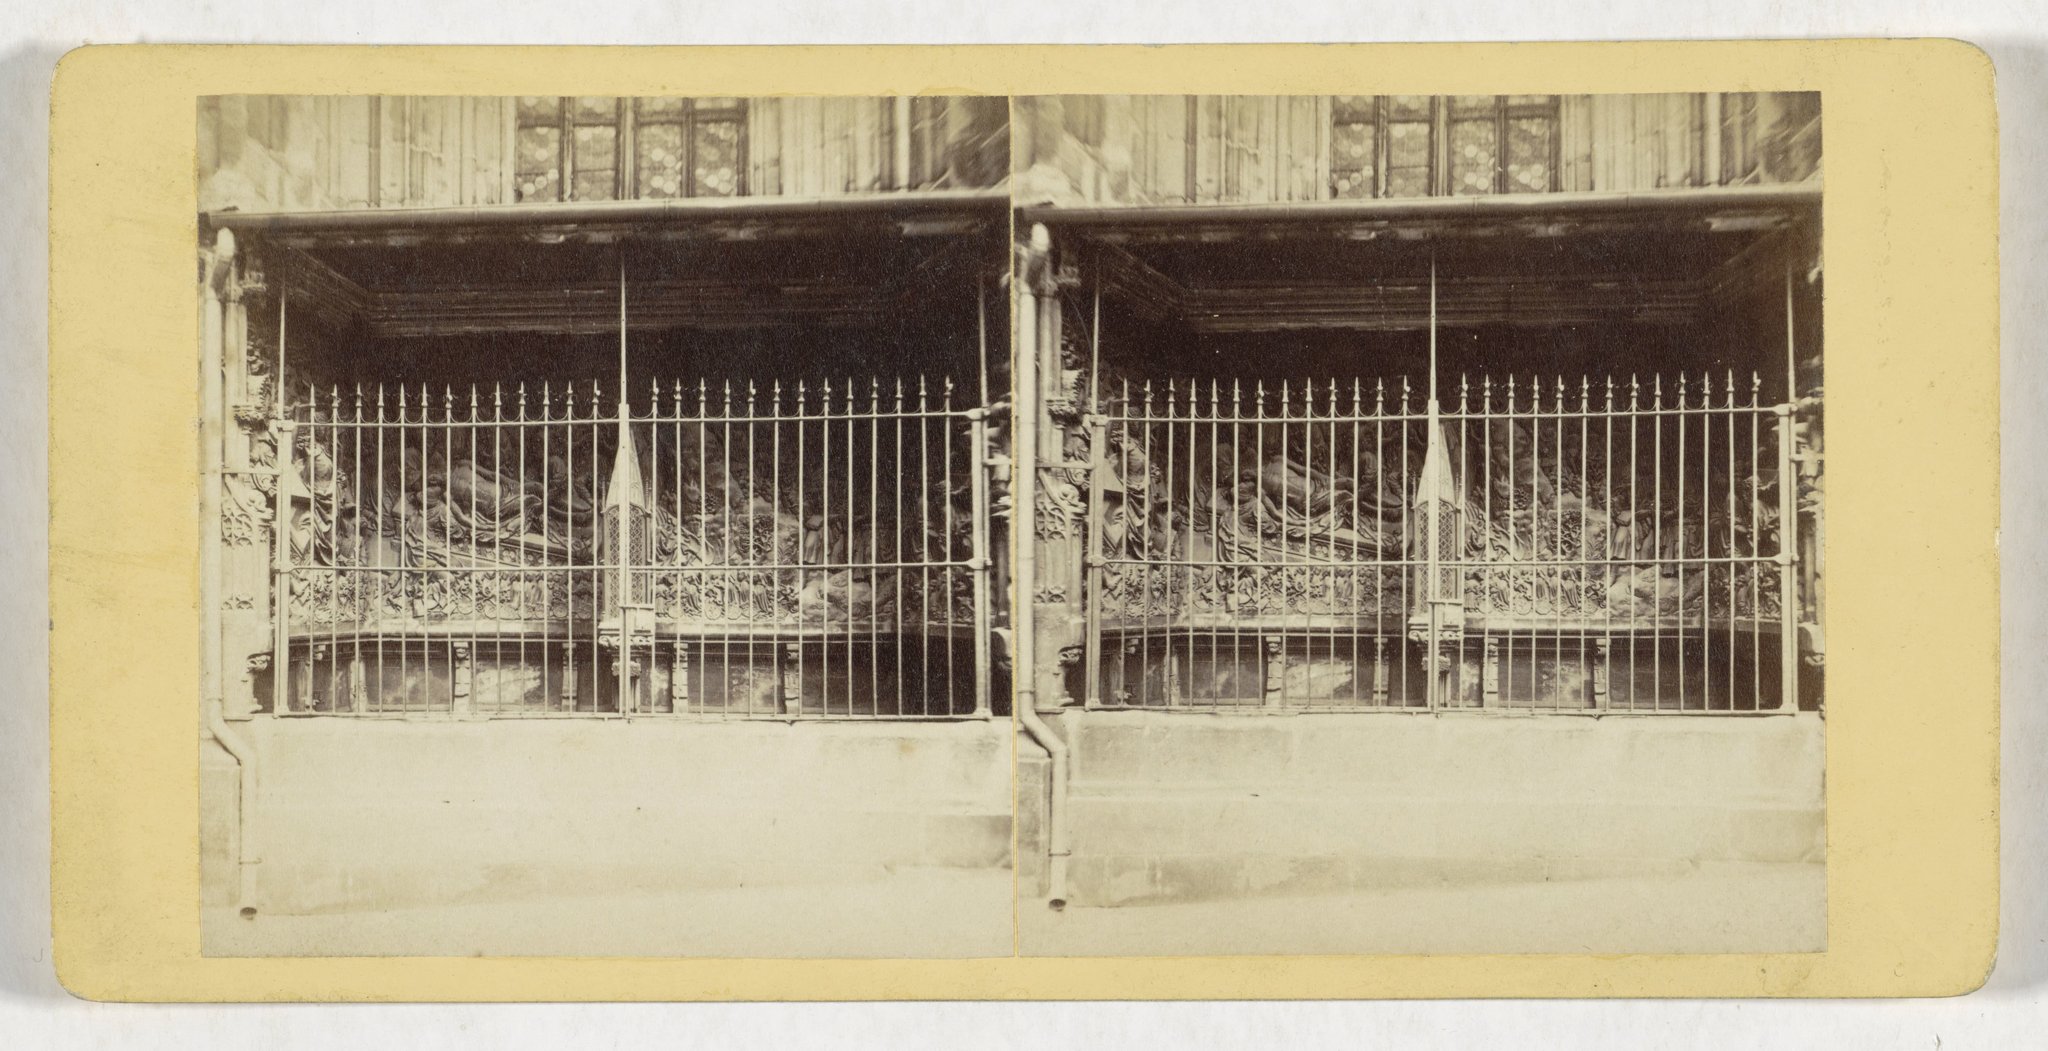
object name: stereograph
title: Grablegung an der Sebaldus-Kirche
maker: johann friedrich stiehm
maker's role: fotograaf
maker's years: 1826-1902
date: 1868-1888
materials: cardboard, paper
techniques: albumen print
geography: london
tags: church (exterior), christ's body on or in the grave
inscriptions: number: ‘No. 32.’